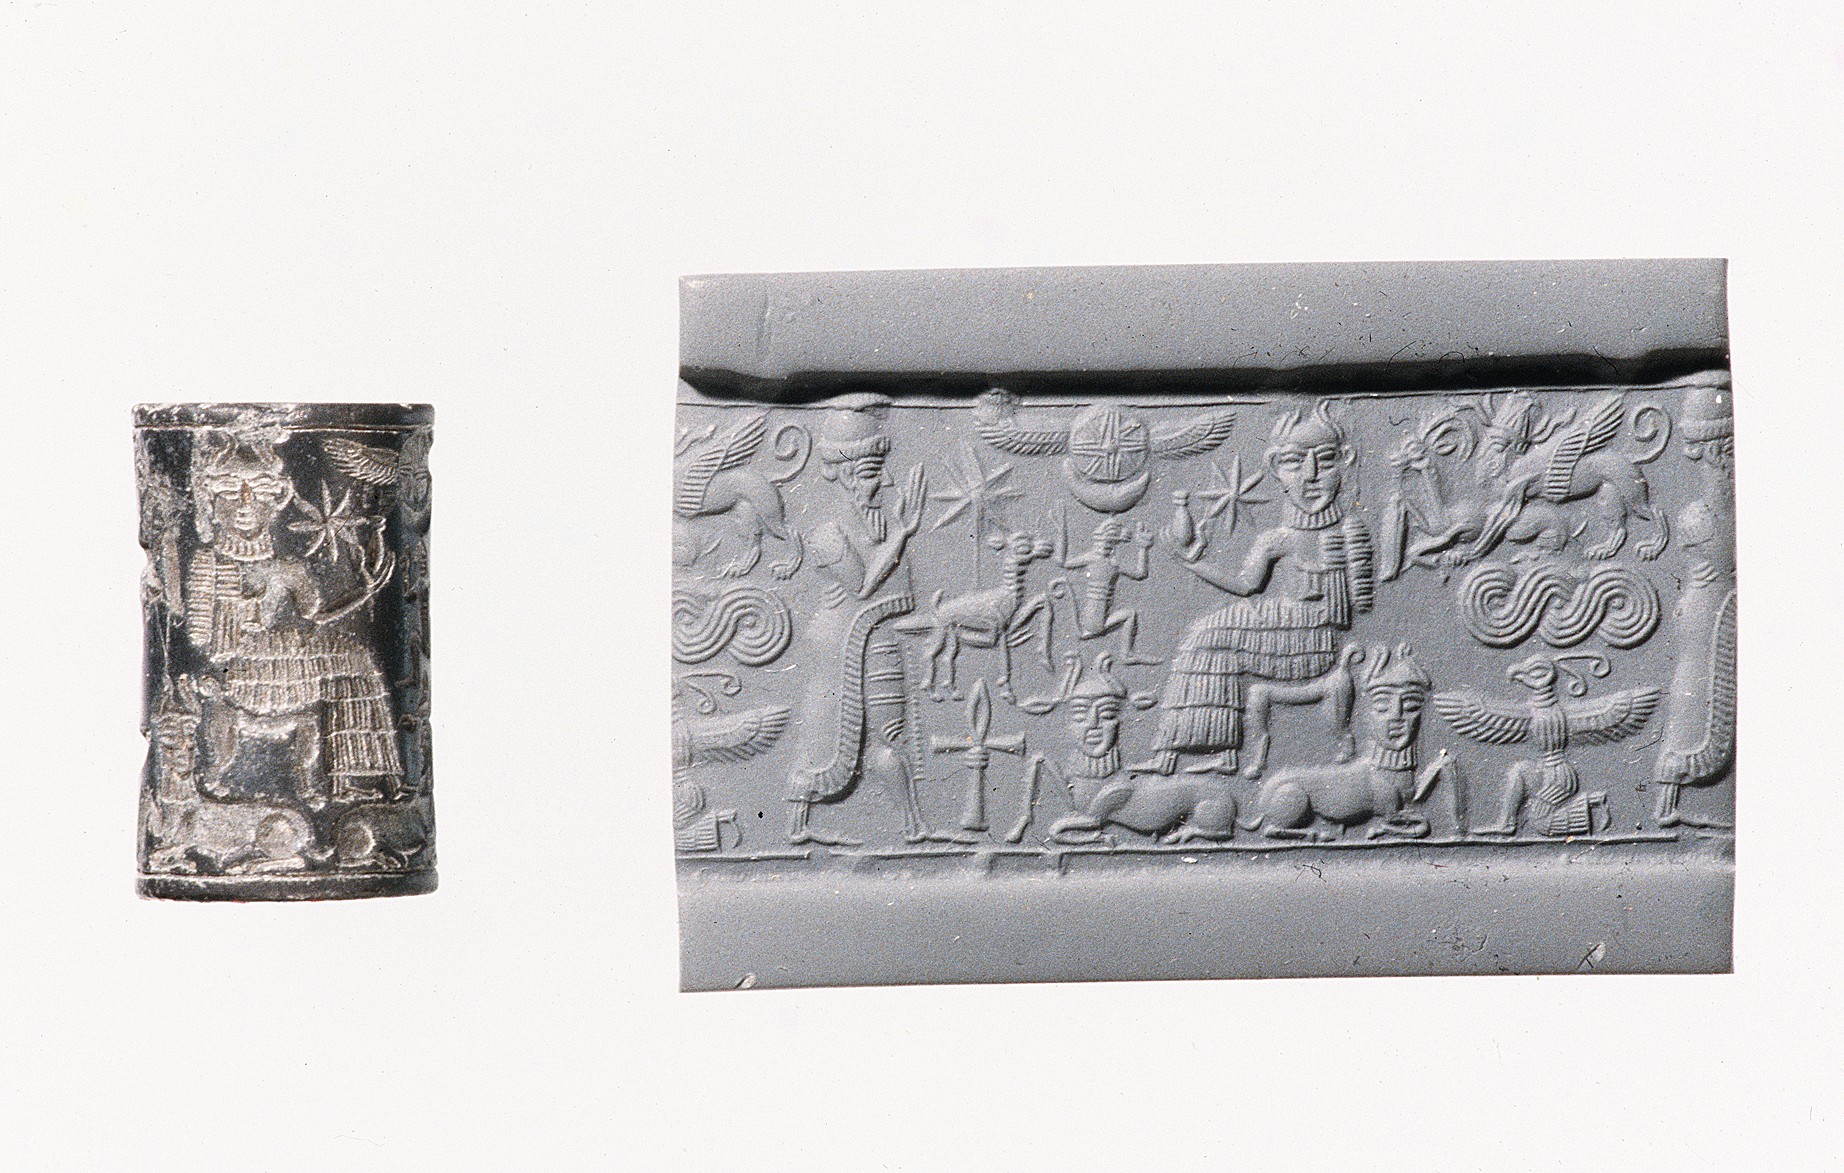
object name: cylinder seal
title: Cylinder seal and modern impression: royal worshiper before a god on a throne; human-headed bulls below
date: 1820-1730 BCE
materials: mineral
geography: syria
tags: men,sphinx,monkeys